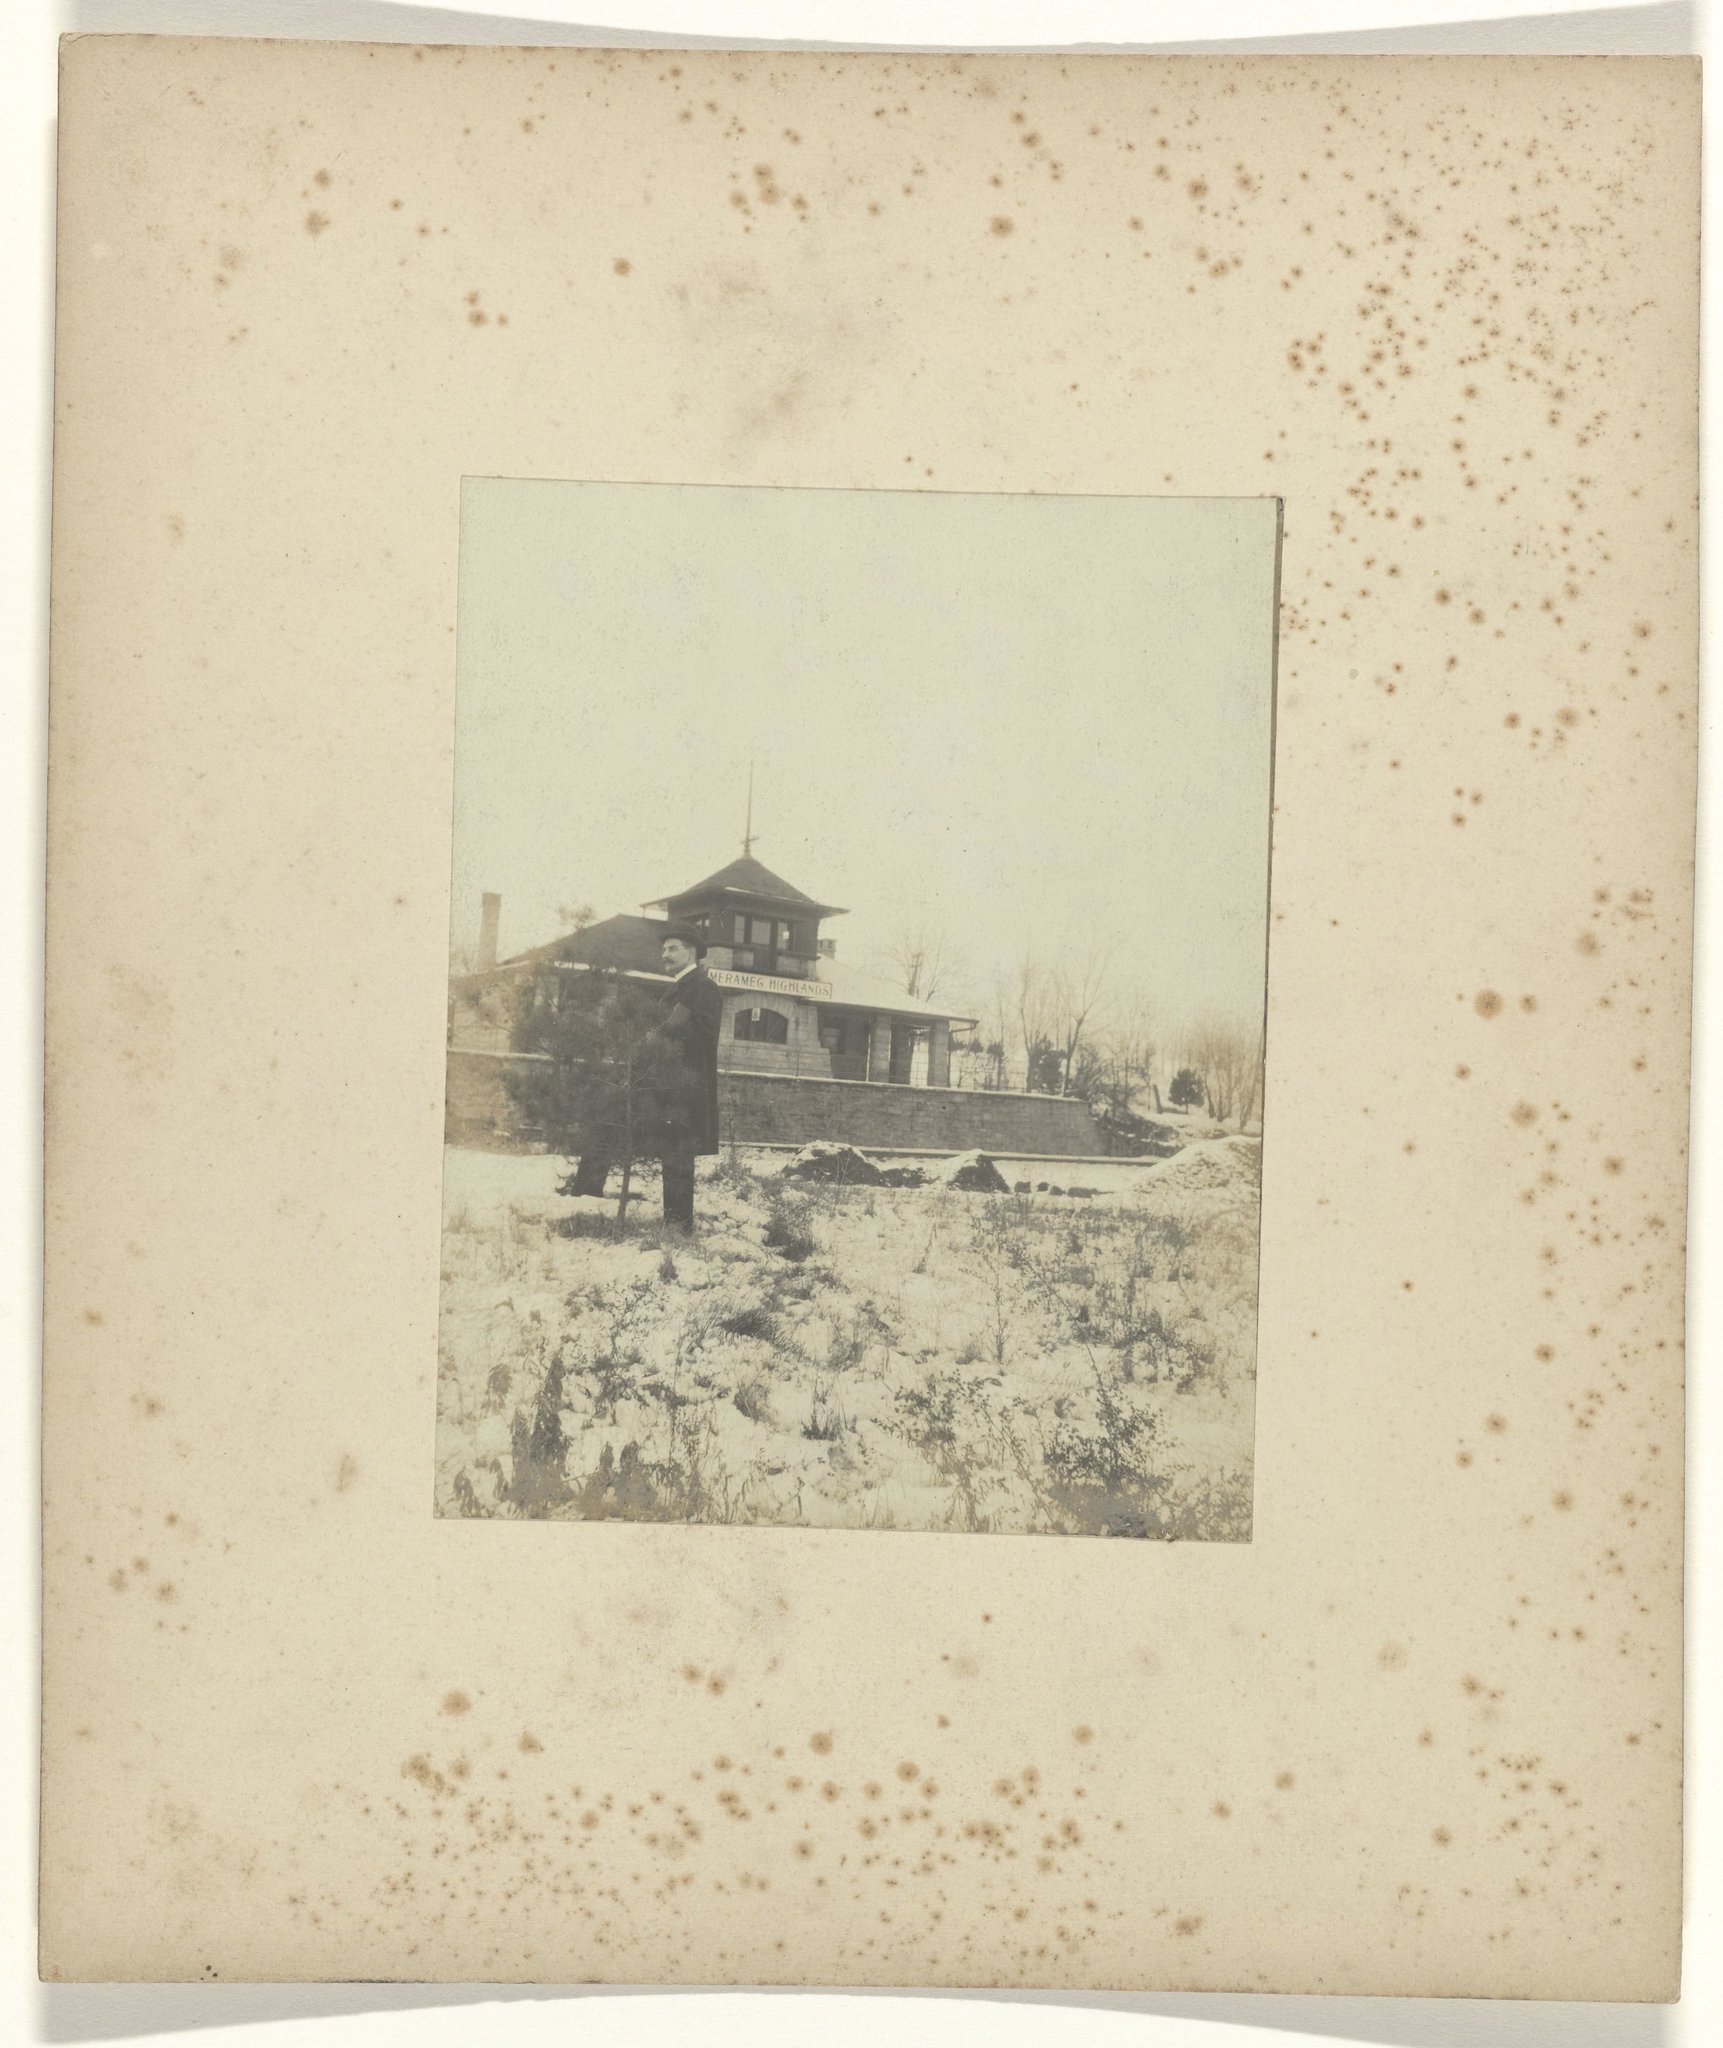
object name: photograph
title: Backers staand voor het station van de Meramec Highlands t tijdens de wereldtentoonstelling in St. Louis (Louisiana Purchase Exposition), 1904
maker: jan schüller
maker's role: draughtsman, painter, print maker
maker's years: 1871-1915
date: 1904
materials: cardboard, paper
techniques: gelatin silver print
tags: missouri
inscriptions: annotation: ‘Backers voor ’t station // Meramec Highlands’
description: Backers staand voor het station van de Meramec Highlands t tijdens de wereldtentoonstelling in St. Louis (Louisiana Purchase Exposition), 1904.